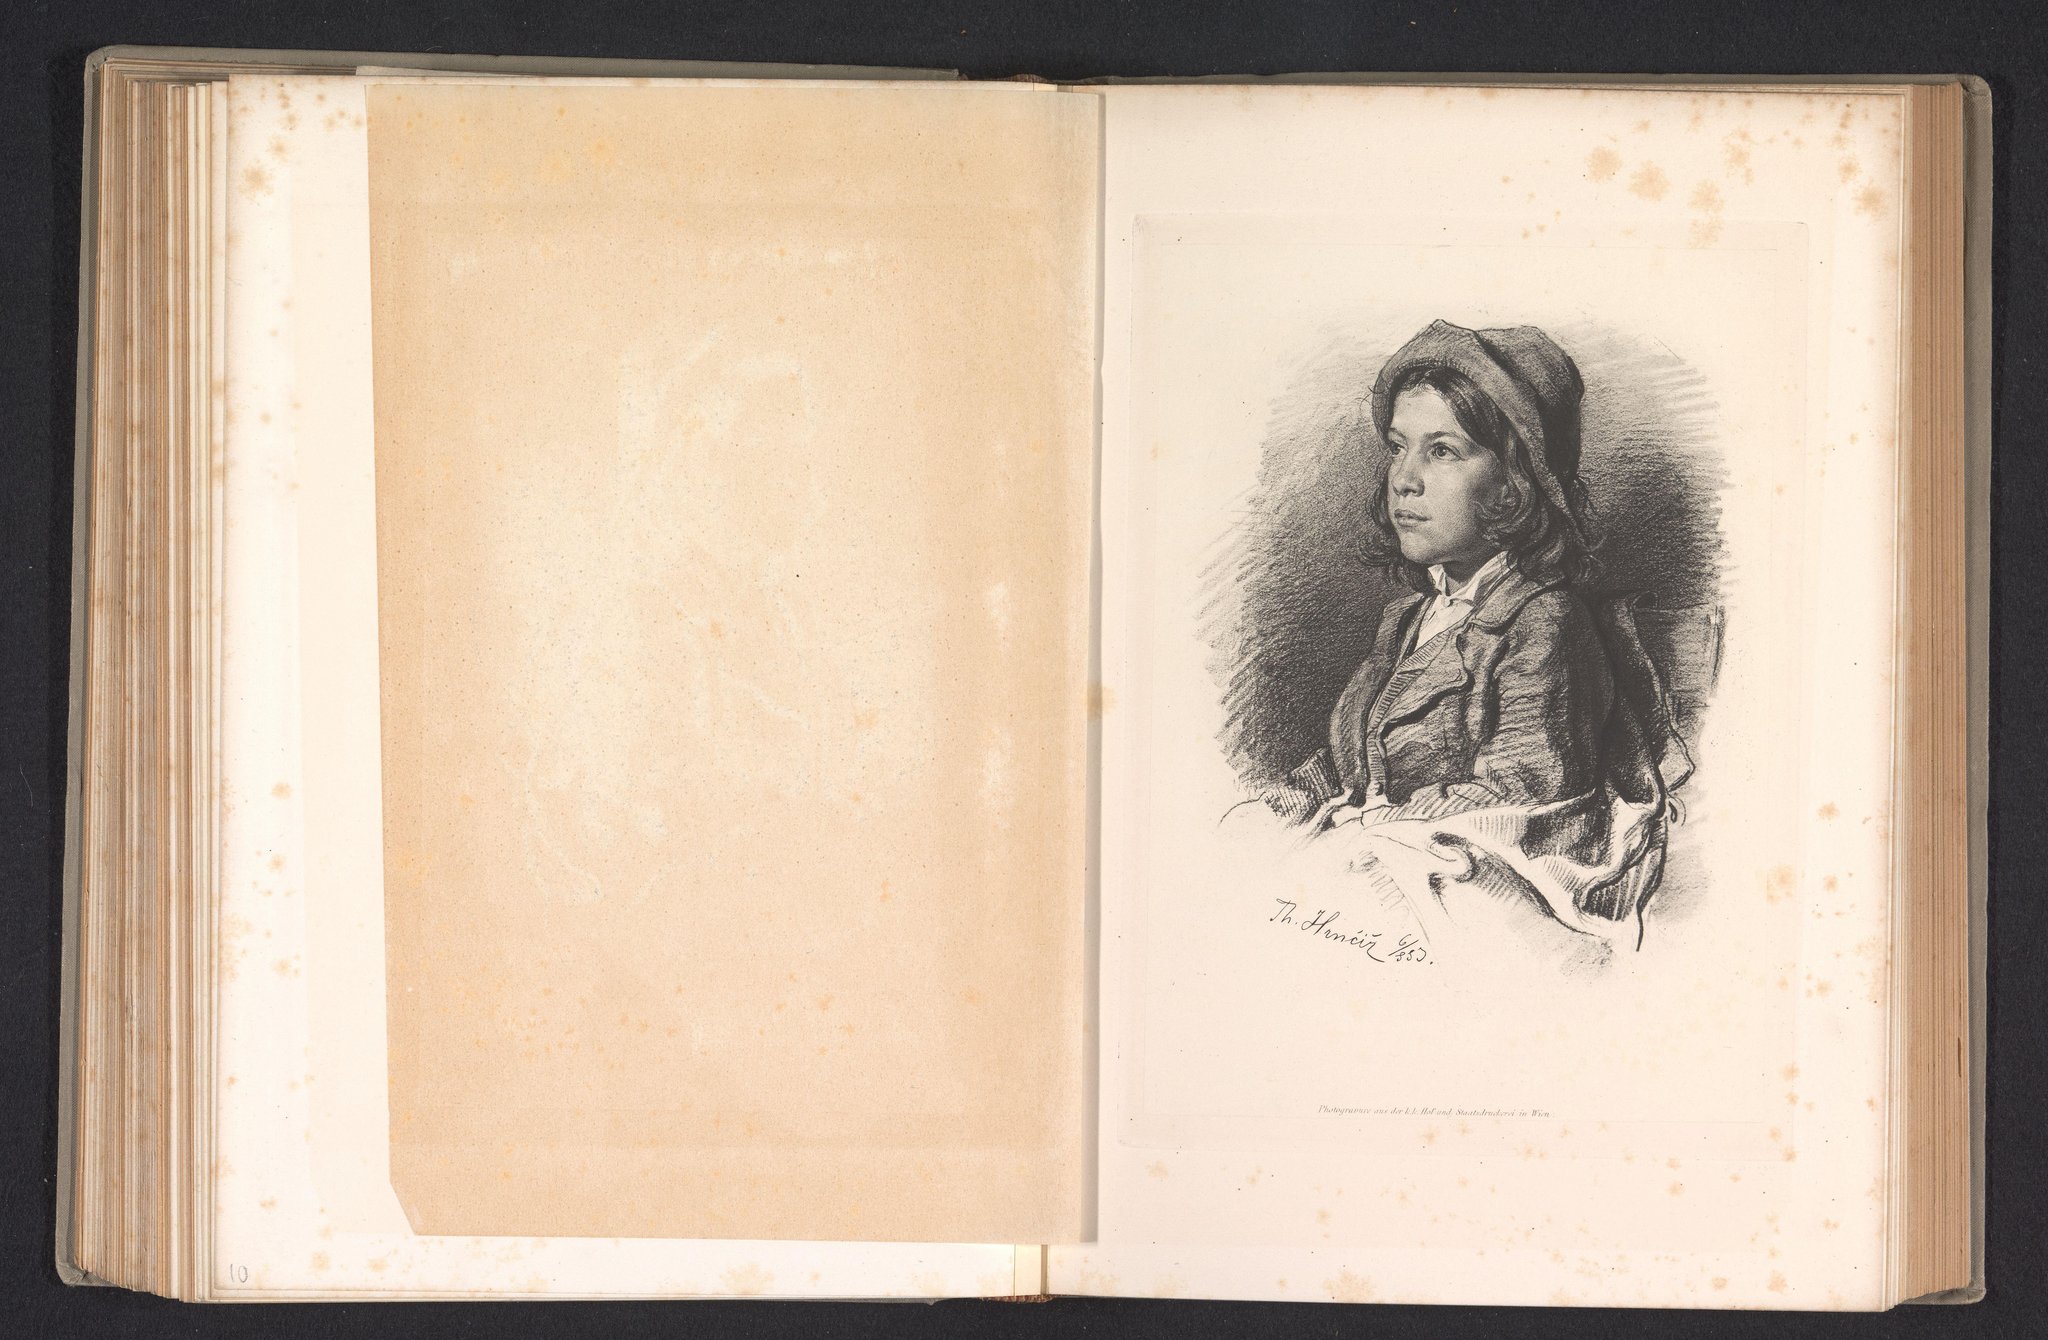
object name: photomechanical print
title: Fotoreproductie van een tekening, voorstellende een portret van een kind met een hoed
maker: Anonymous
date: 1878-1883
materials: paper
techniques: photoaquatint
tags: child, head-gear: hat